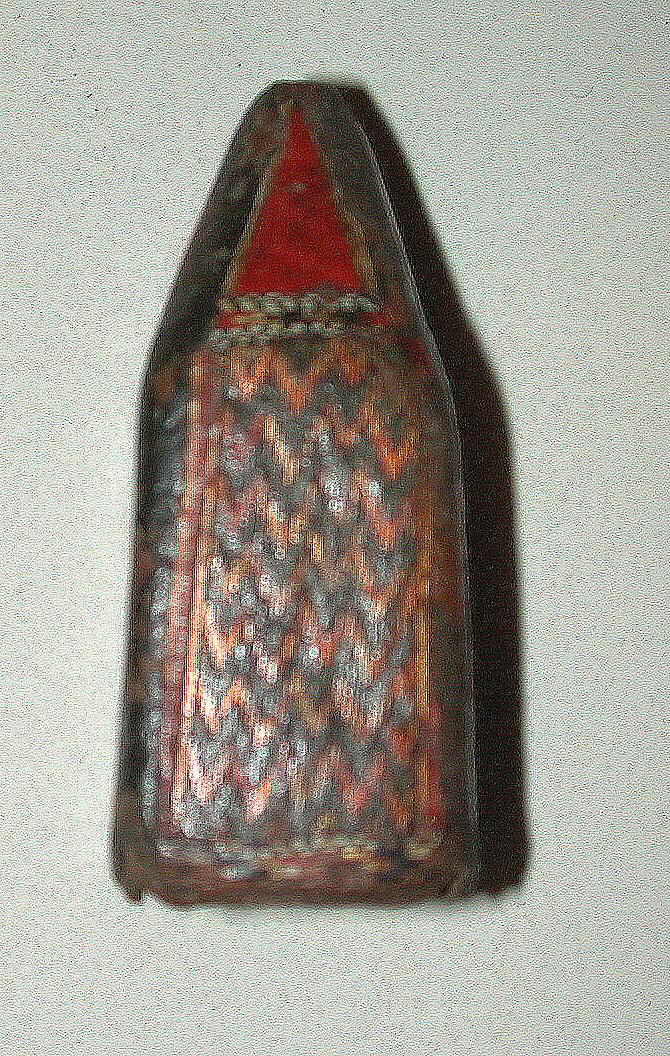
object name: finial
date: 1101-1300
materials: wood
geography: probably eastern islamic lands